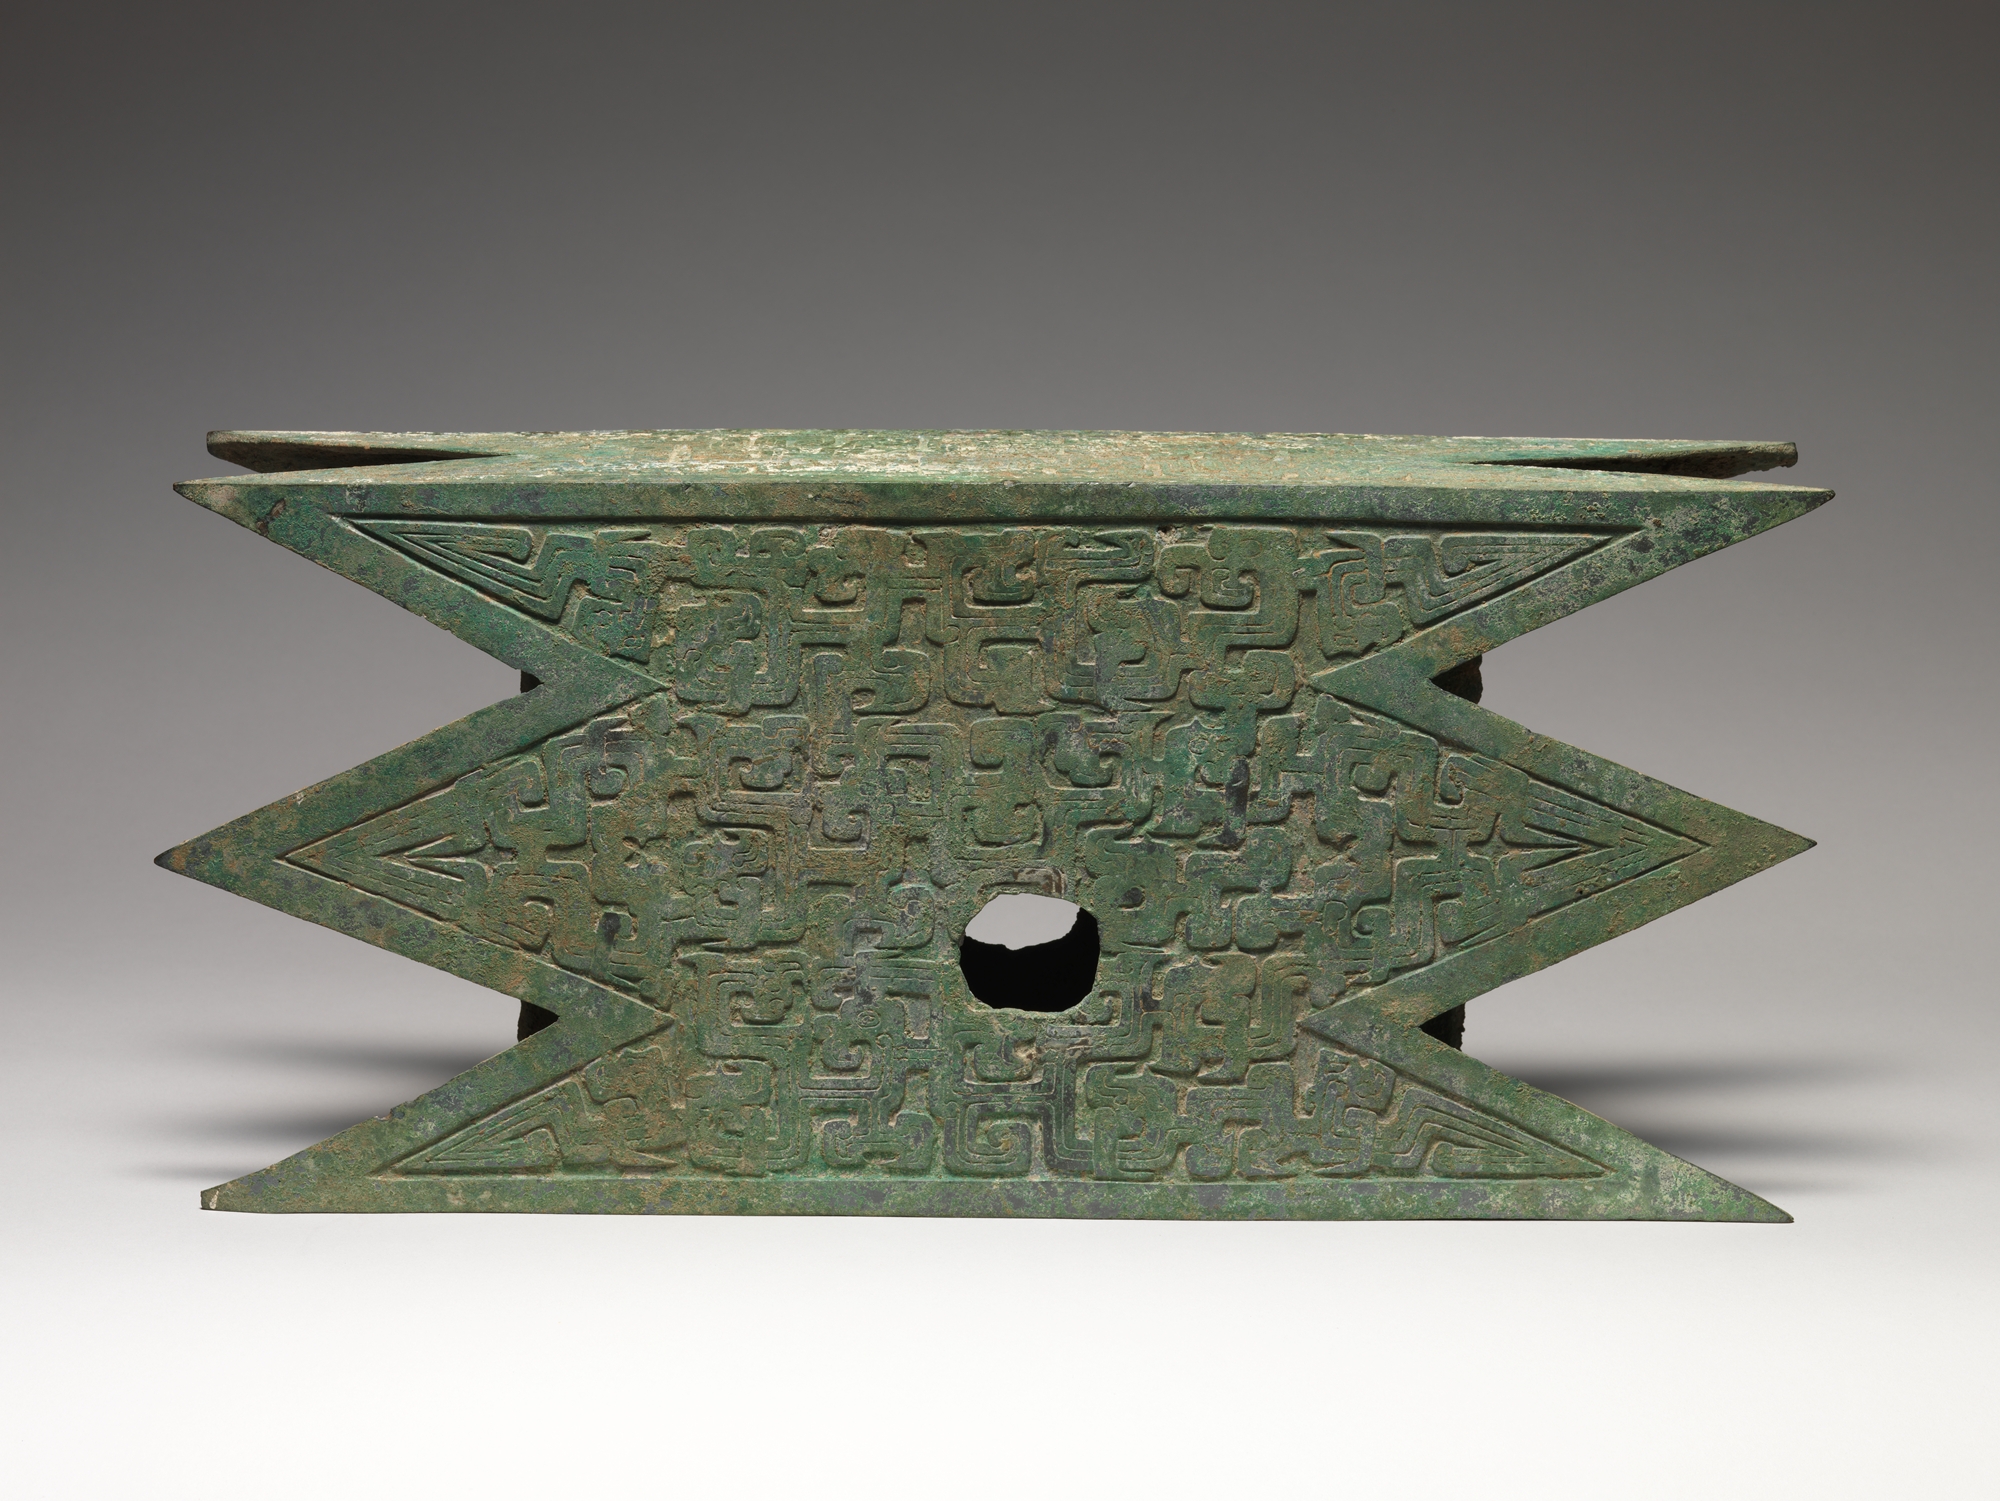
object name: architectural unit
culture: chinese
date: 1046-256 BCE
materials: bronze, patina